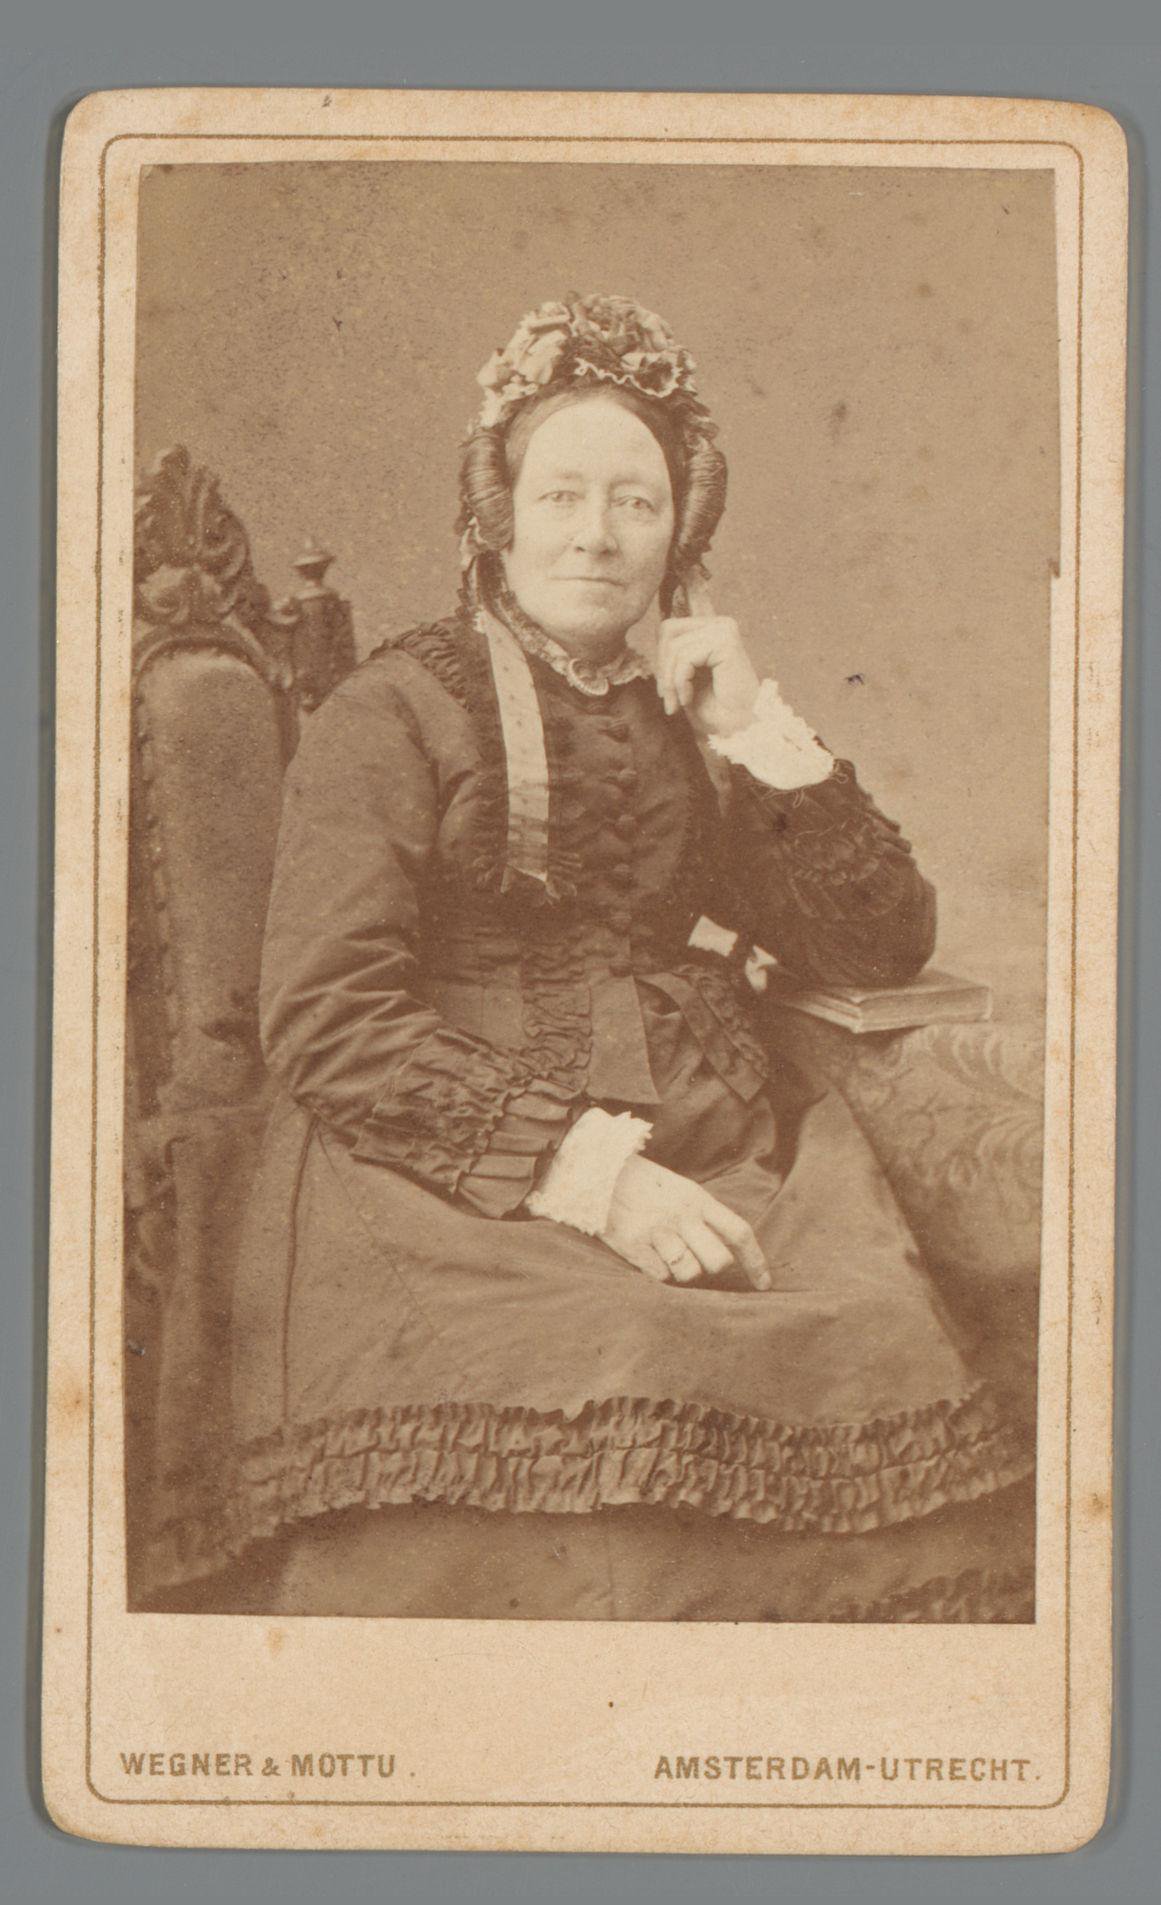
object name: carte de visite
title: Portret van Maria Engelina Jonker van Zijp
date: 1877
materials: cardboard, photographic support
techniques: albumen print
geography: amsterdam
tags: historical persons, amsterdam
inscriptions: annotation: ‘Grootmoeder Jonker v. Zijp’, workshop stamp: ‘Photographisch Artistisch Atelier van/ Wegner & Mottu/ Amsterdam, Rokin over de Bank 138/ Utrecht, Leijdschestraatweg 153’